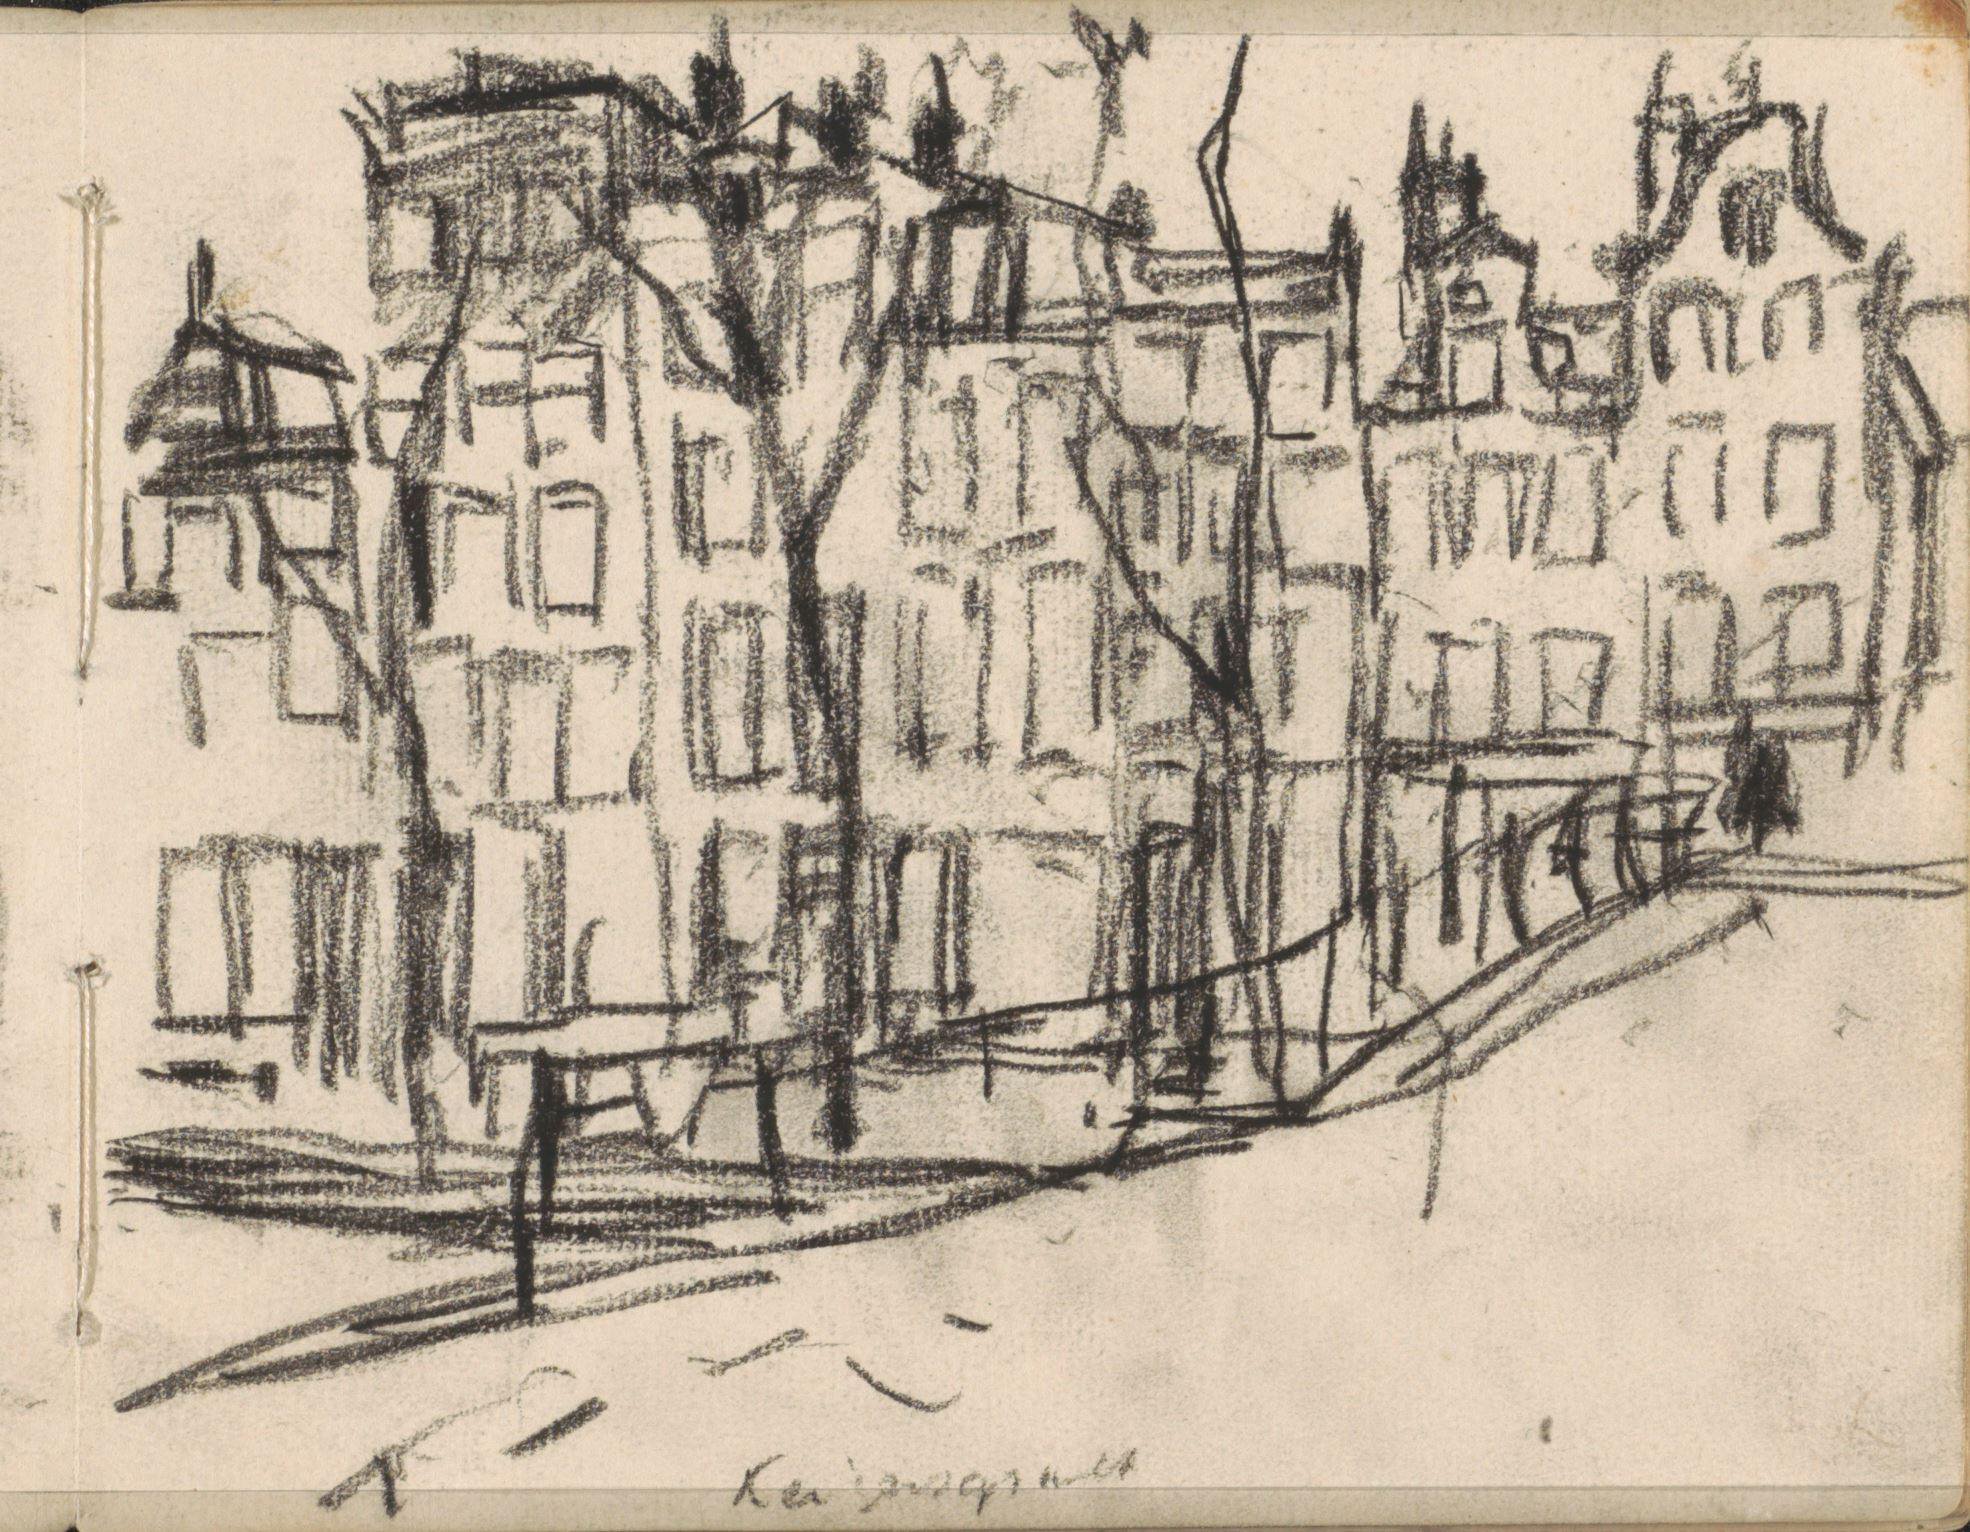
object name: sketchbook leaf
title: Brug over de Keizersgracht te Amsterdam ter hoogte van de Berenstraat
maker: george hendrik breitner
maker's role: draughtsman, painter, print maker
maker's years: 1857-1923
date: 1893-1899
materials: chalk, paper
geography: amsterdam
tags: urban housing, bridge in city across river, canal, etc.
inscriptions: annotation: ‘Keizersgracht’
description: Pagina 10 uit een schetsboek met 28 bladen.